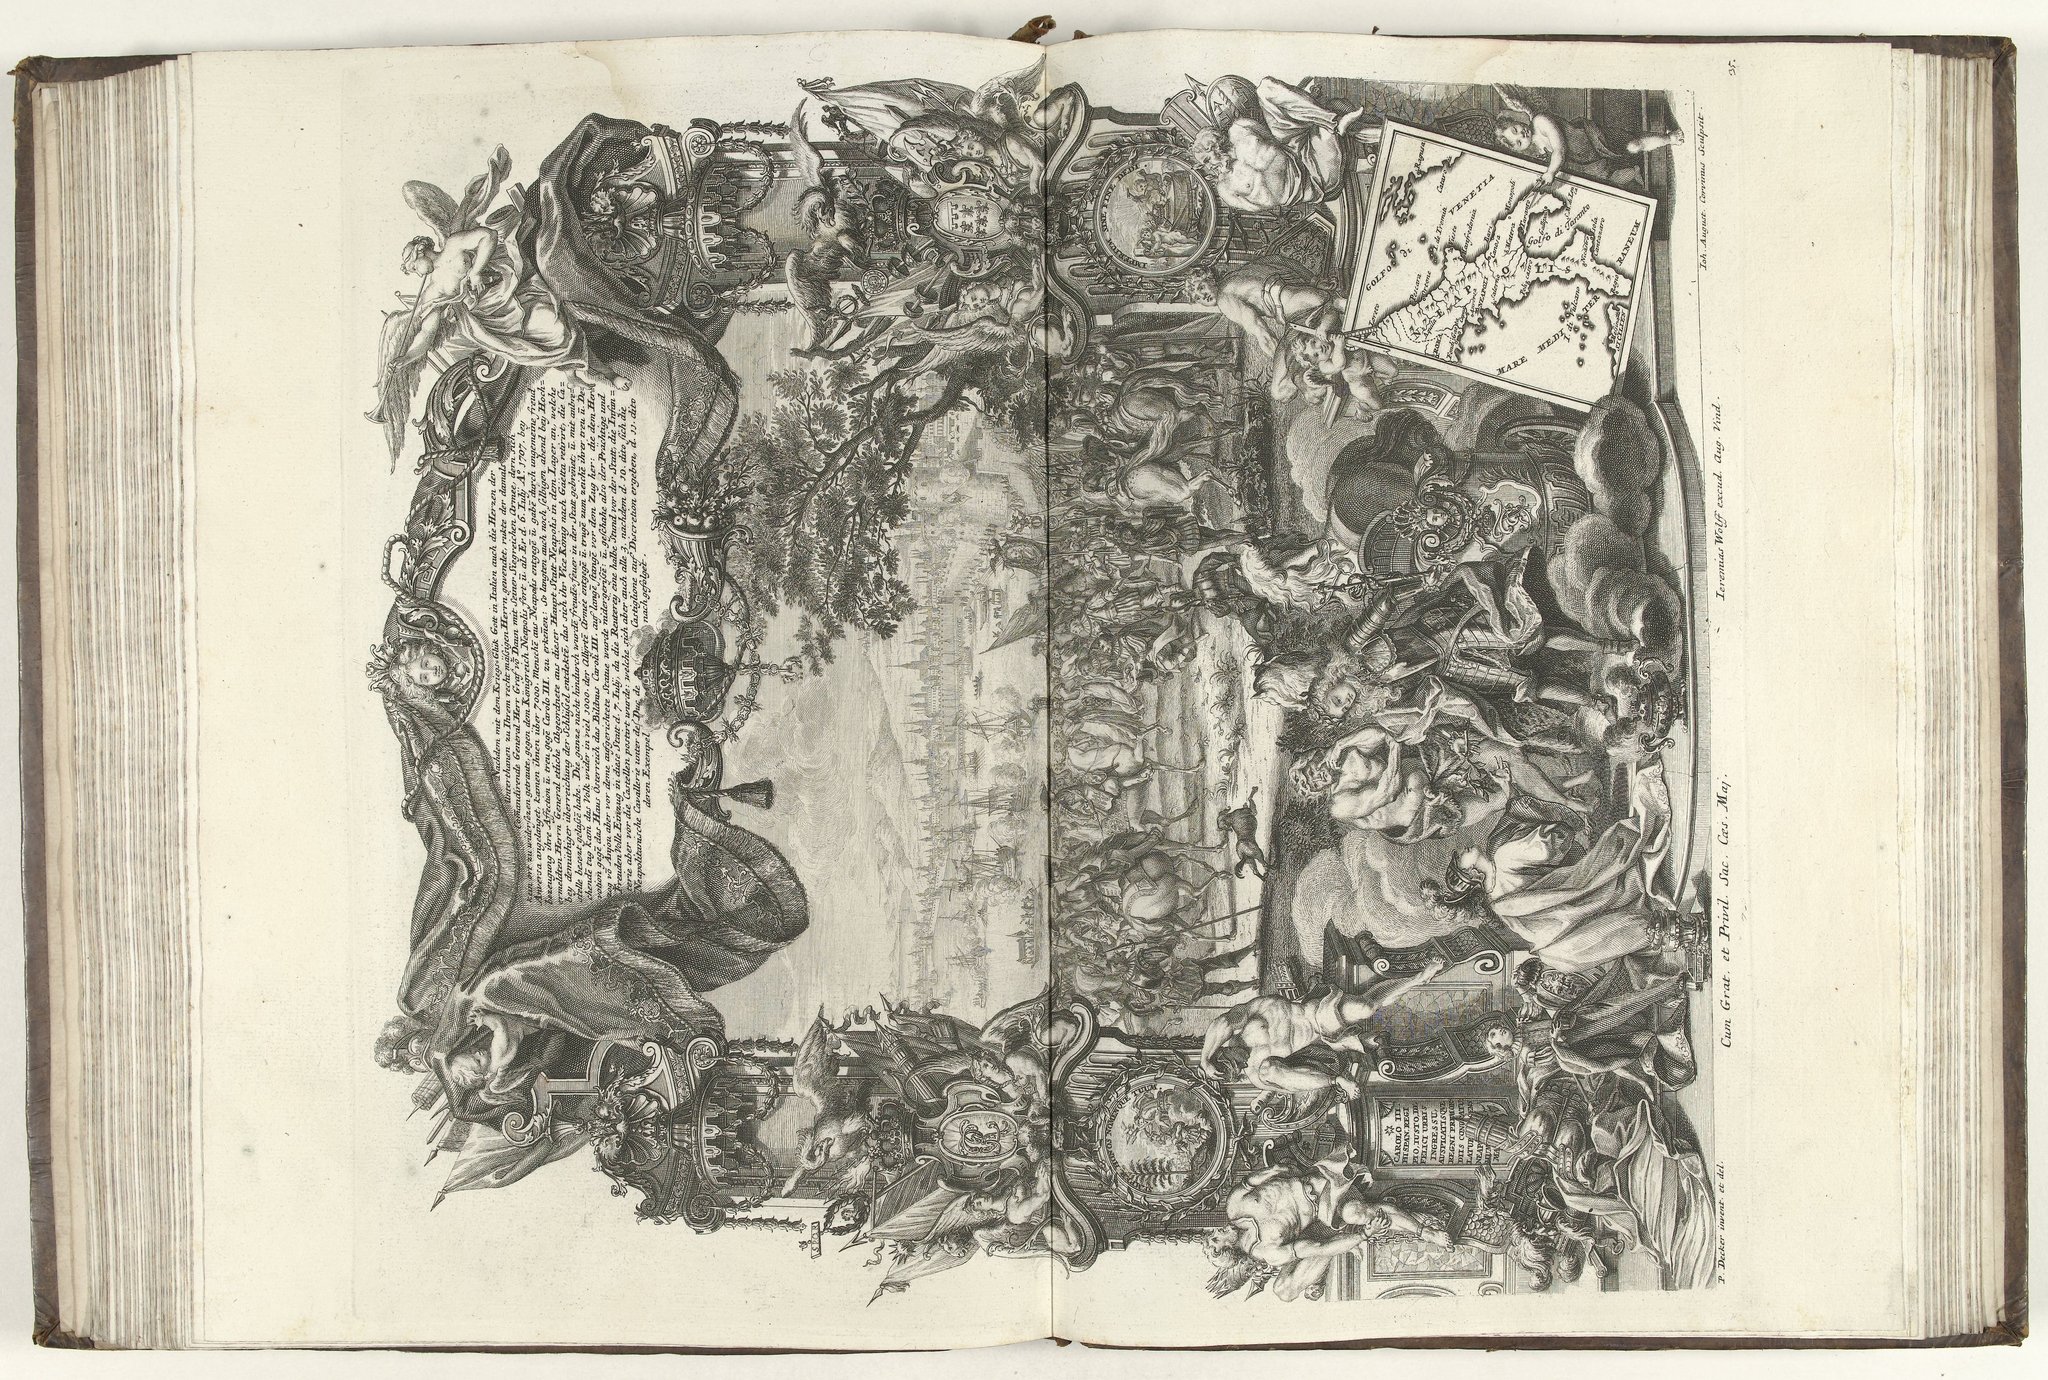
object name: history print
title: Onderwerping van Napels aan Karel III, 1707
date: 1712-1715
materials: paper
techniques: engraving, etching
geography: augsburg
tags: vienna, charles vi (holy roman emperor), surrender of keys, naples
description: De bewoners van de stad Napels overhandigen de sleutels van de stad aan generaal Von Daun die namens koning Karel III de stad inneemt, 6 juli 1707. De centrale voorstelling van de sleuteloverdracht in een zeer rijk versierde ornamentele omlijsting met bovenaan een cartouche met de beschrijving van de gebeurtenissen in het Duits. Onderaan een allegorische voorstelling waarin een knielende figuur de vredestak overhandigt aan koning Karel III (aartshertog Karel van Oostenrijk) die met zijn triomfwagen en begeleid door Hercules op de wolken voor haar staat. Blad in de gebonden verzameling platen uitgebracht onder de titel: Repraesentatio belli ... Der Spanische Successions-Krieg [ca. 1720].